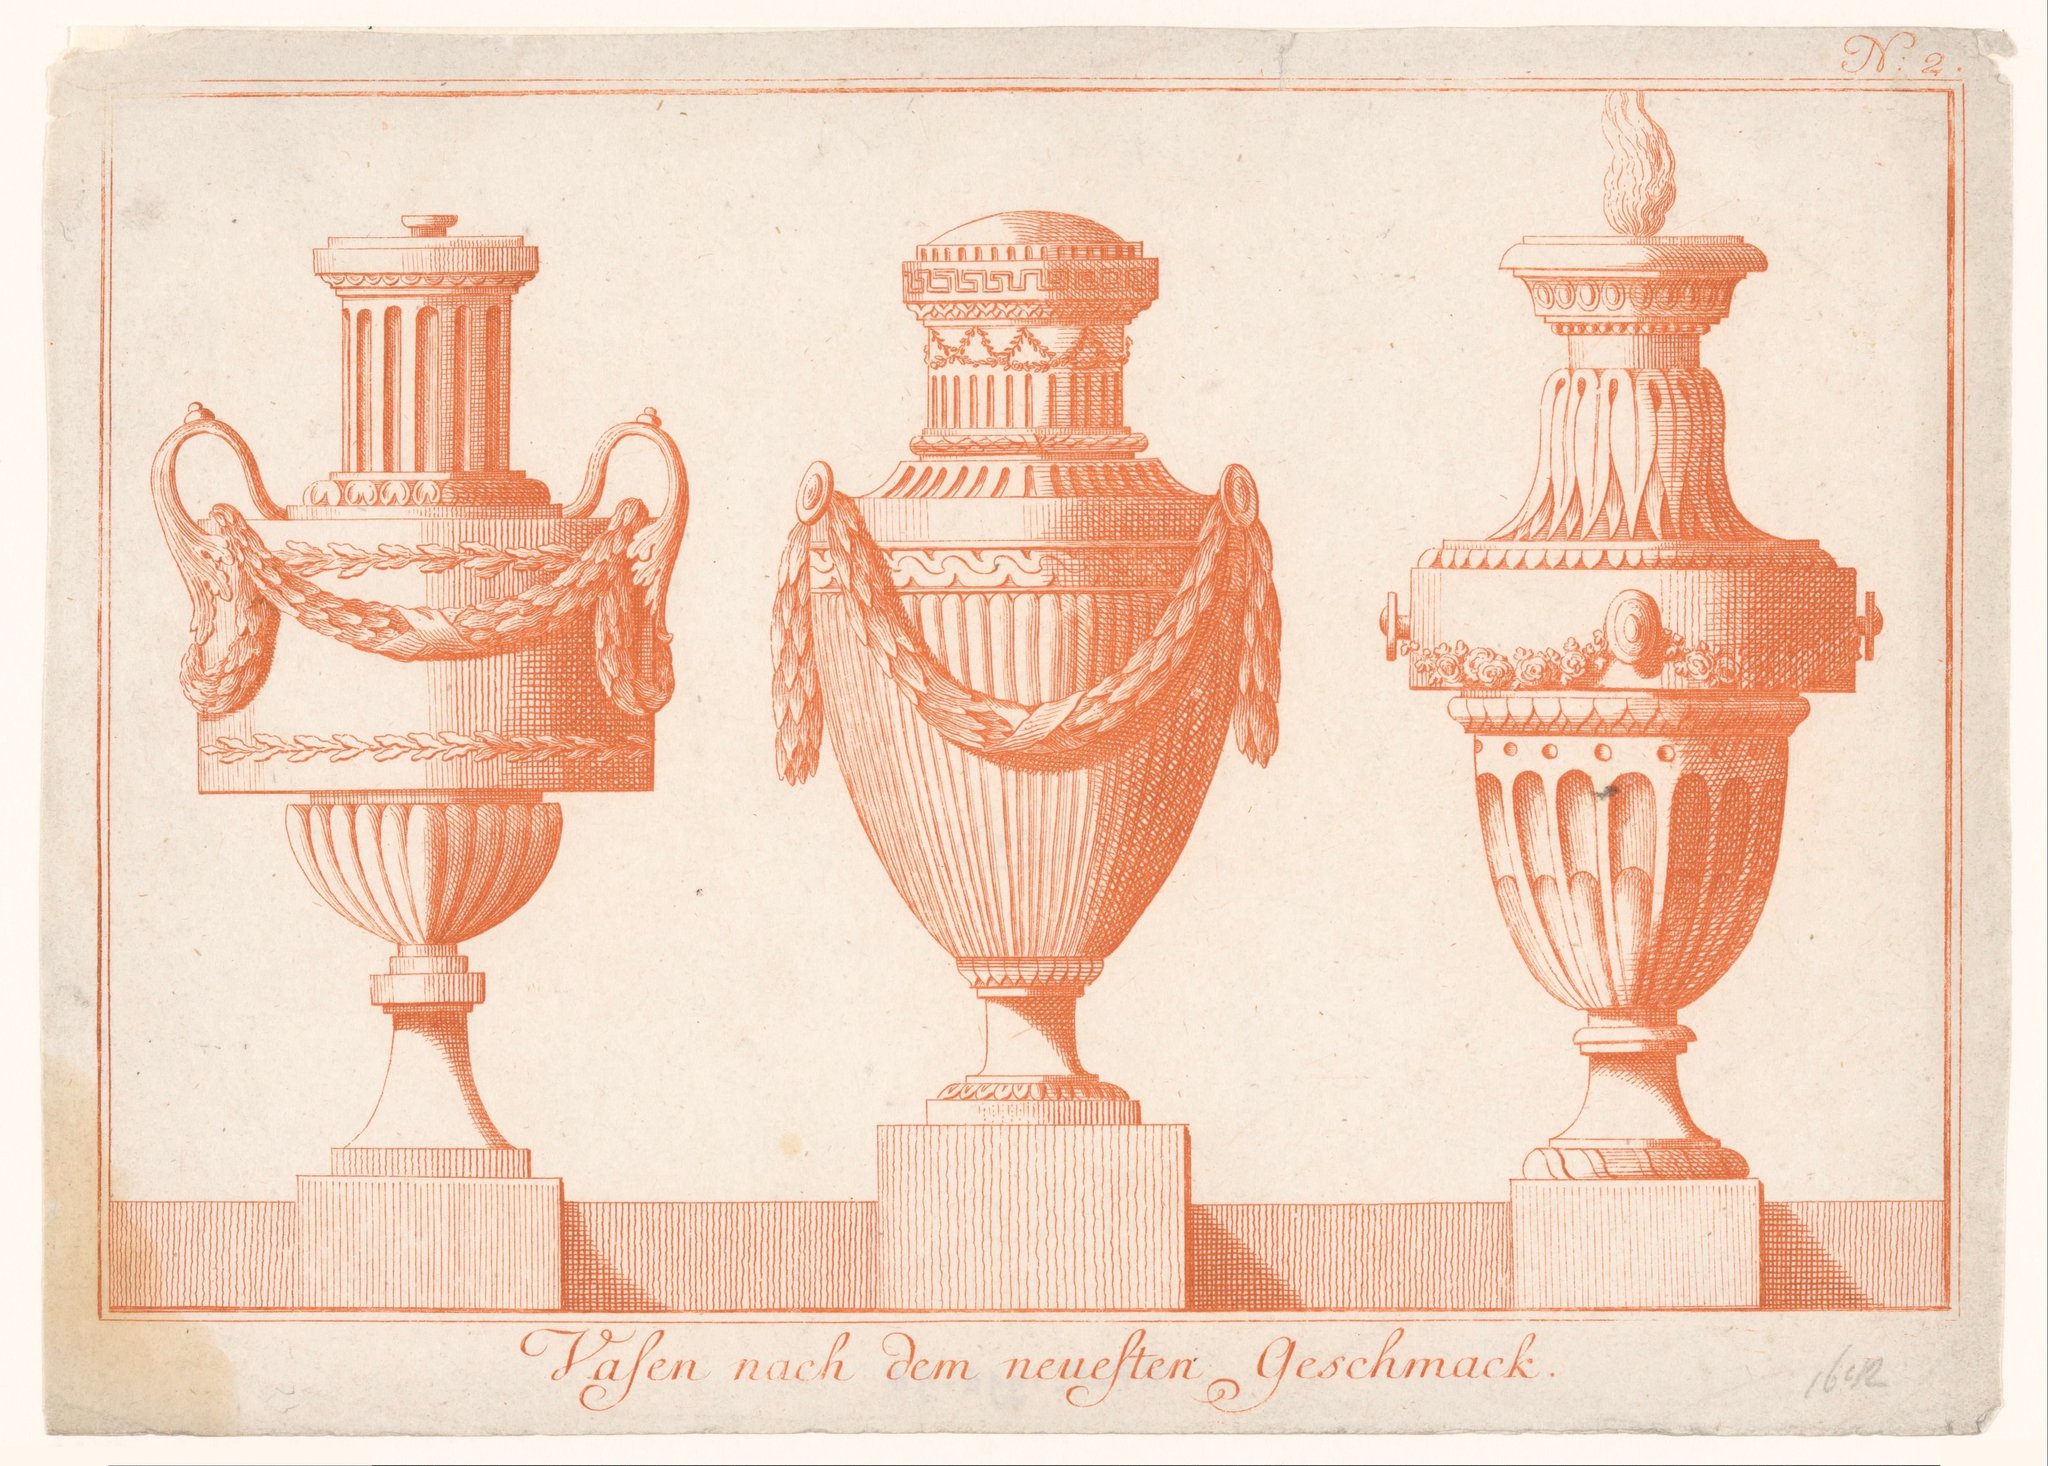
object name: ornament print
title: Drie vazen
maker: Anonymous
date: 1750-1788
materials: paper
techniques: etching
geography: kriegshaber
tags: vase ~ ornament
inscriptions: collector's mark: Lugt 2228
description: Drie ornamentele vazen met guirlandes. Links met twee oren, rechts met een vlam.